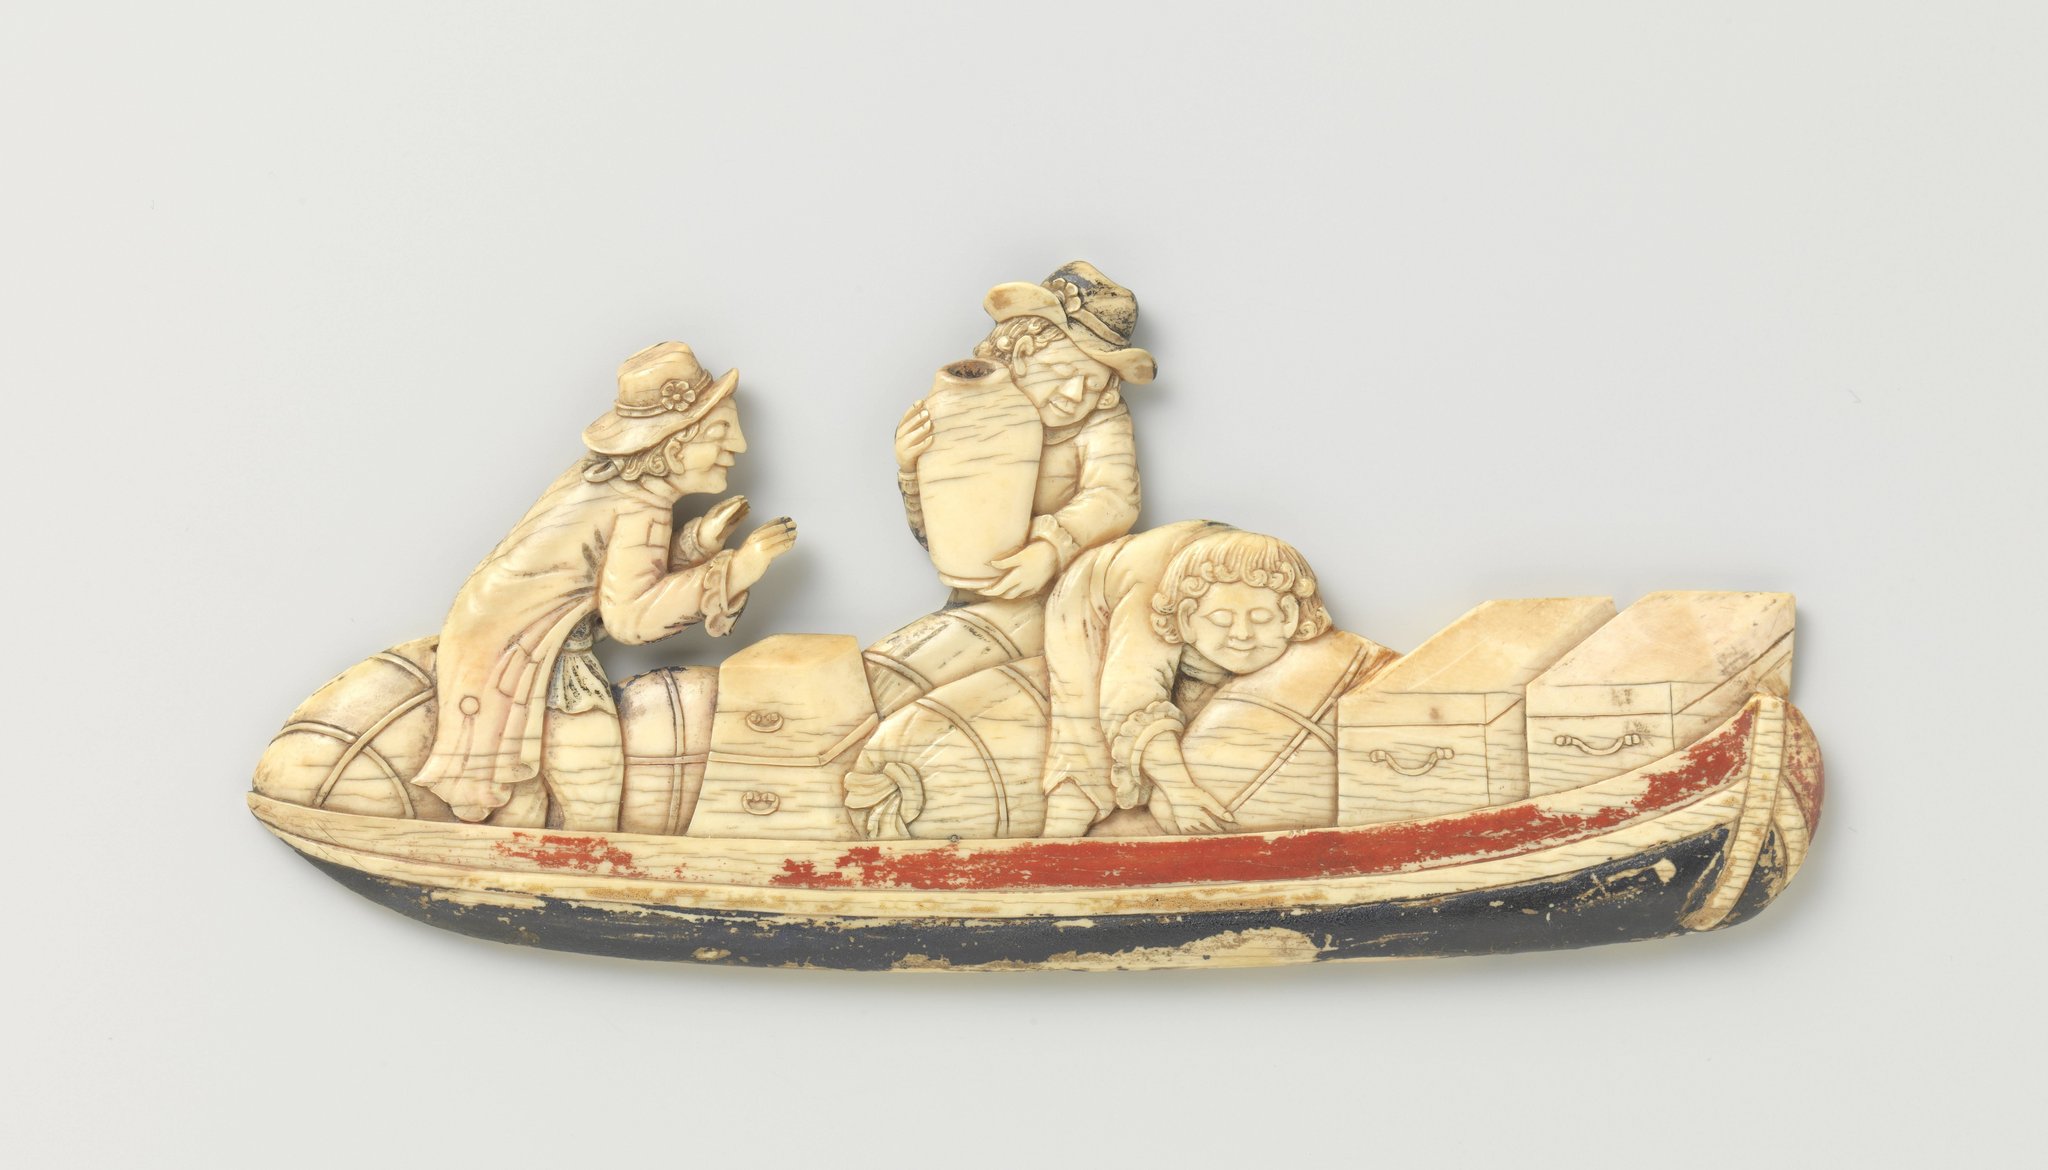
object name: plaque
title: Three Dutchmen in a Sloop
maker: Anonymous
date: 1725-1750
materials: ivory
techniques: painted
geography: china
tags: verenigde oostindische compagnie, kanton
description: A boat is loaded with merchandise, packed in crates, bags, and an earthenware vessel. The man in charge is gesturing at the other men to be careful. Given the colours of the boat, they must be Dutch. Such sloops transported purchased goods from the quay to the large merchant ships off the coast. This object was made in Canton (now Ghuangzou), the Chinese port where many Europeans conducted trade.